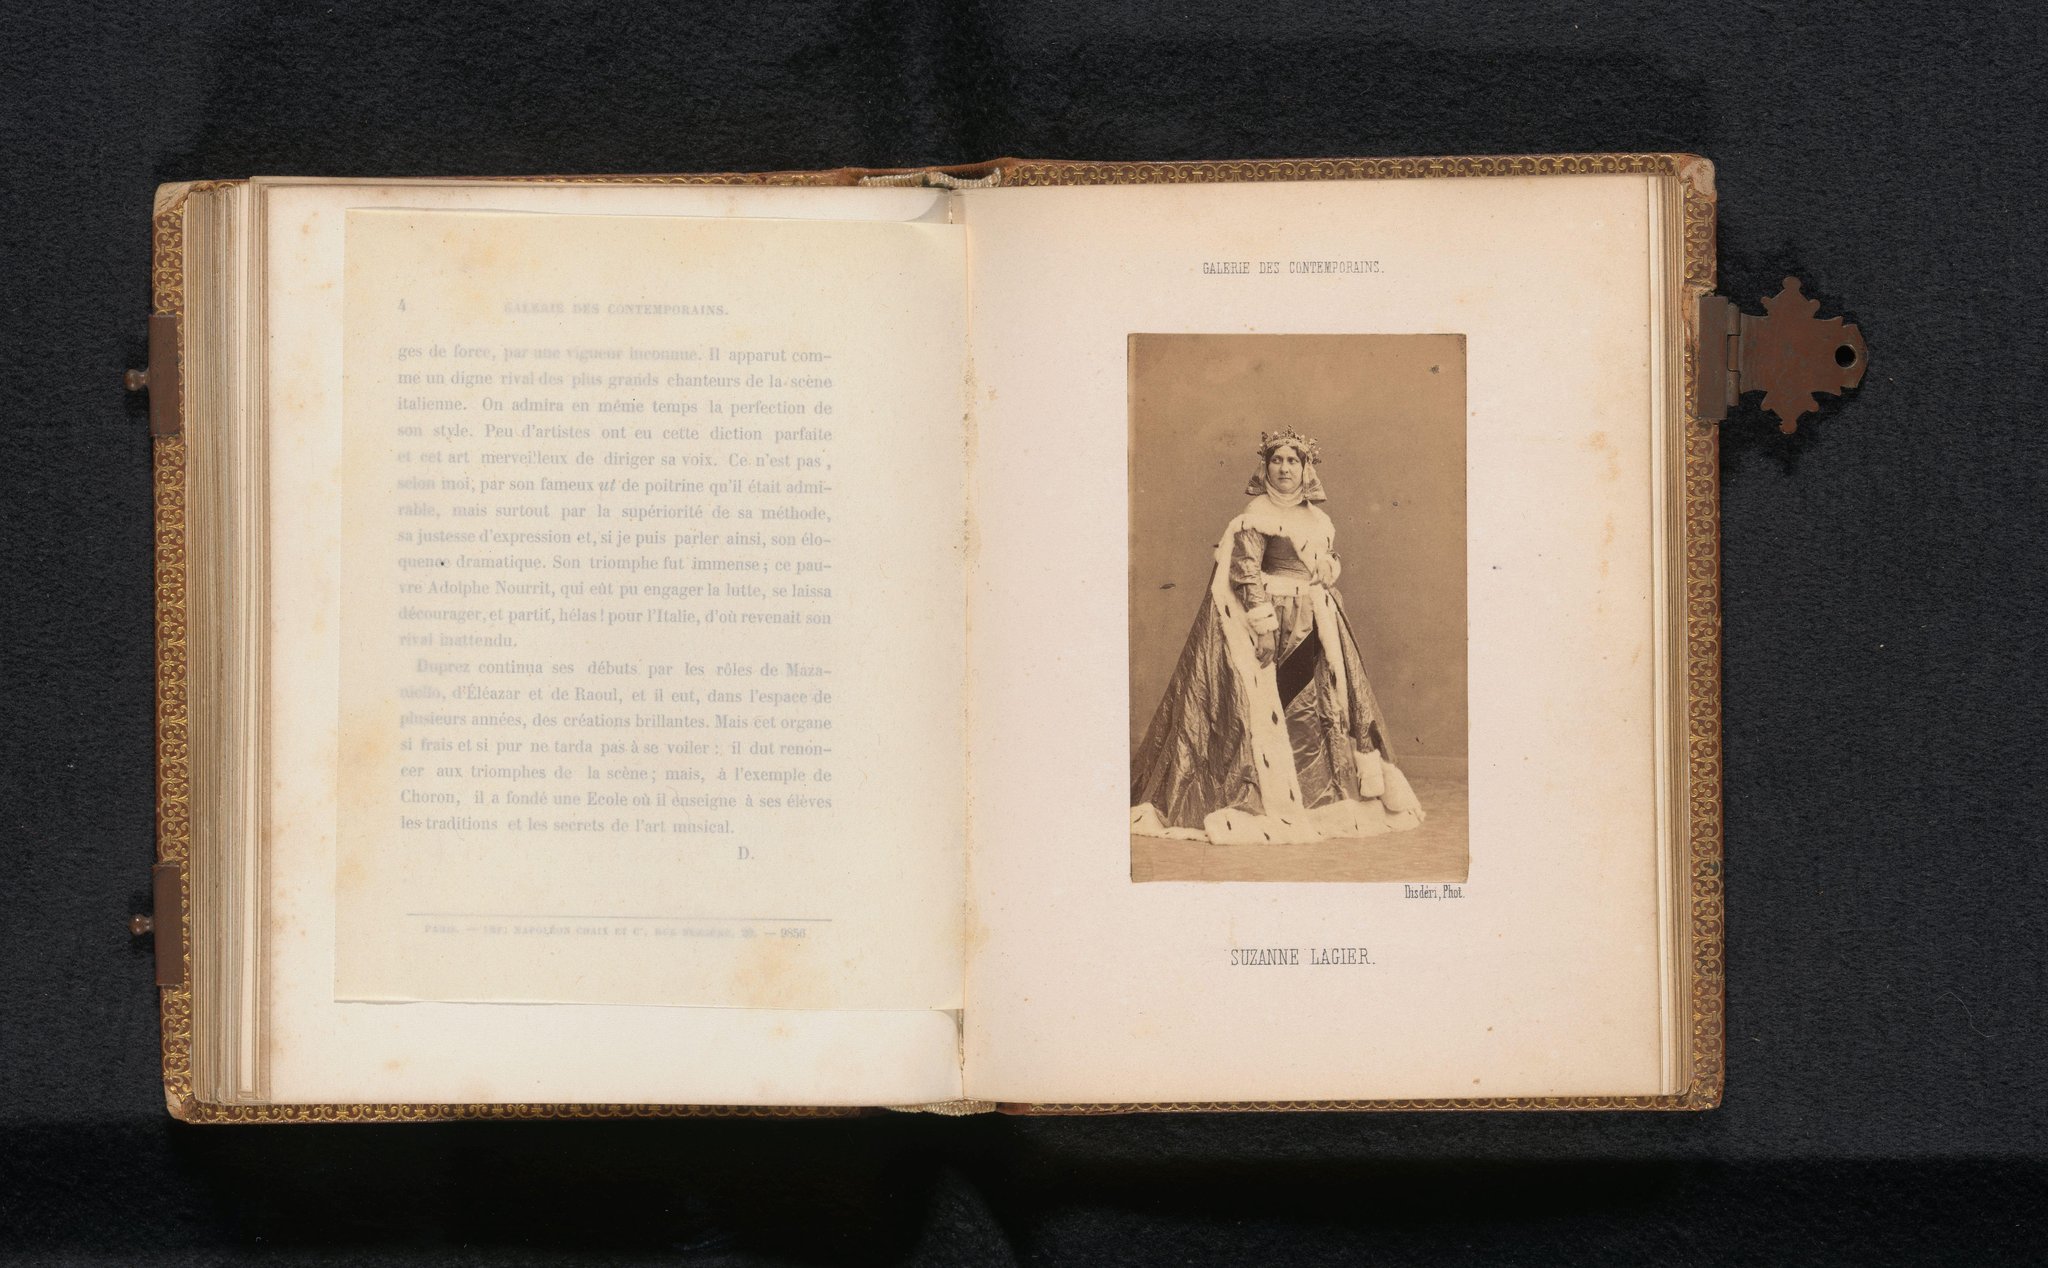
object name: page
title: Suzanne Lagier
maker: andré-adolphe-eugène disdéri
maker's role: fotograaf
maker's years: 1819-1889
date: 1857-1862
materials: photographic support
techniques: albumen print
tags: adult woman, historical persons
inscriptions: inscription: ‘Galerie des Contemporains’